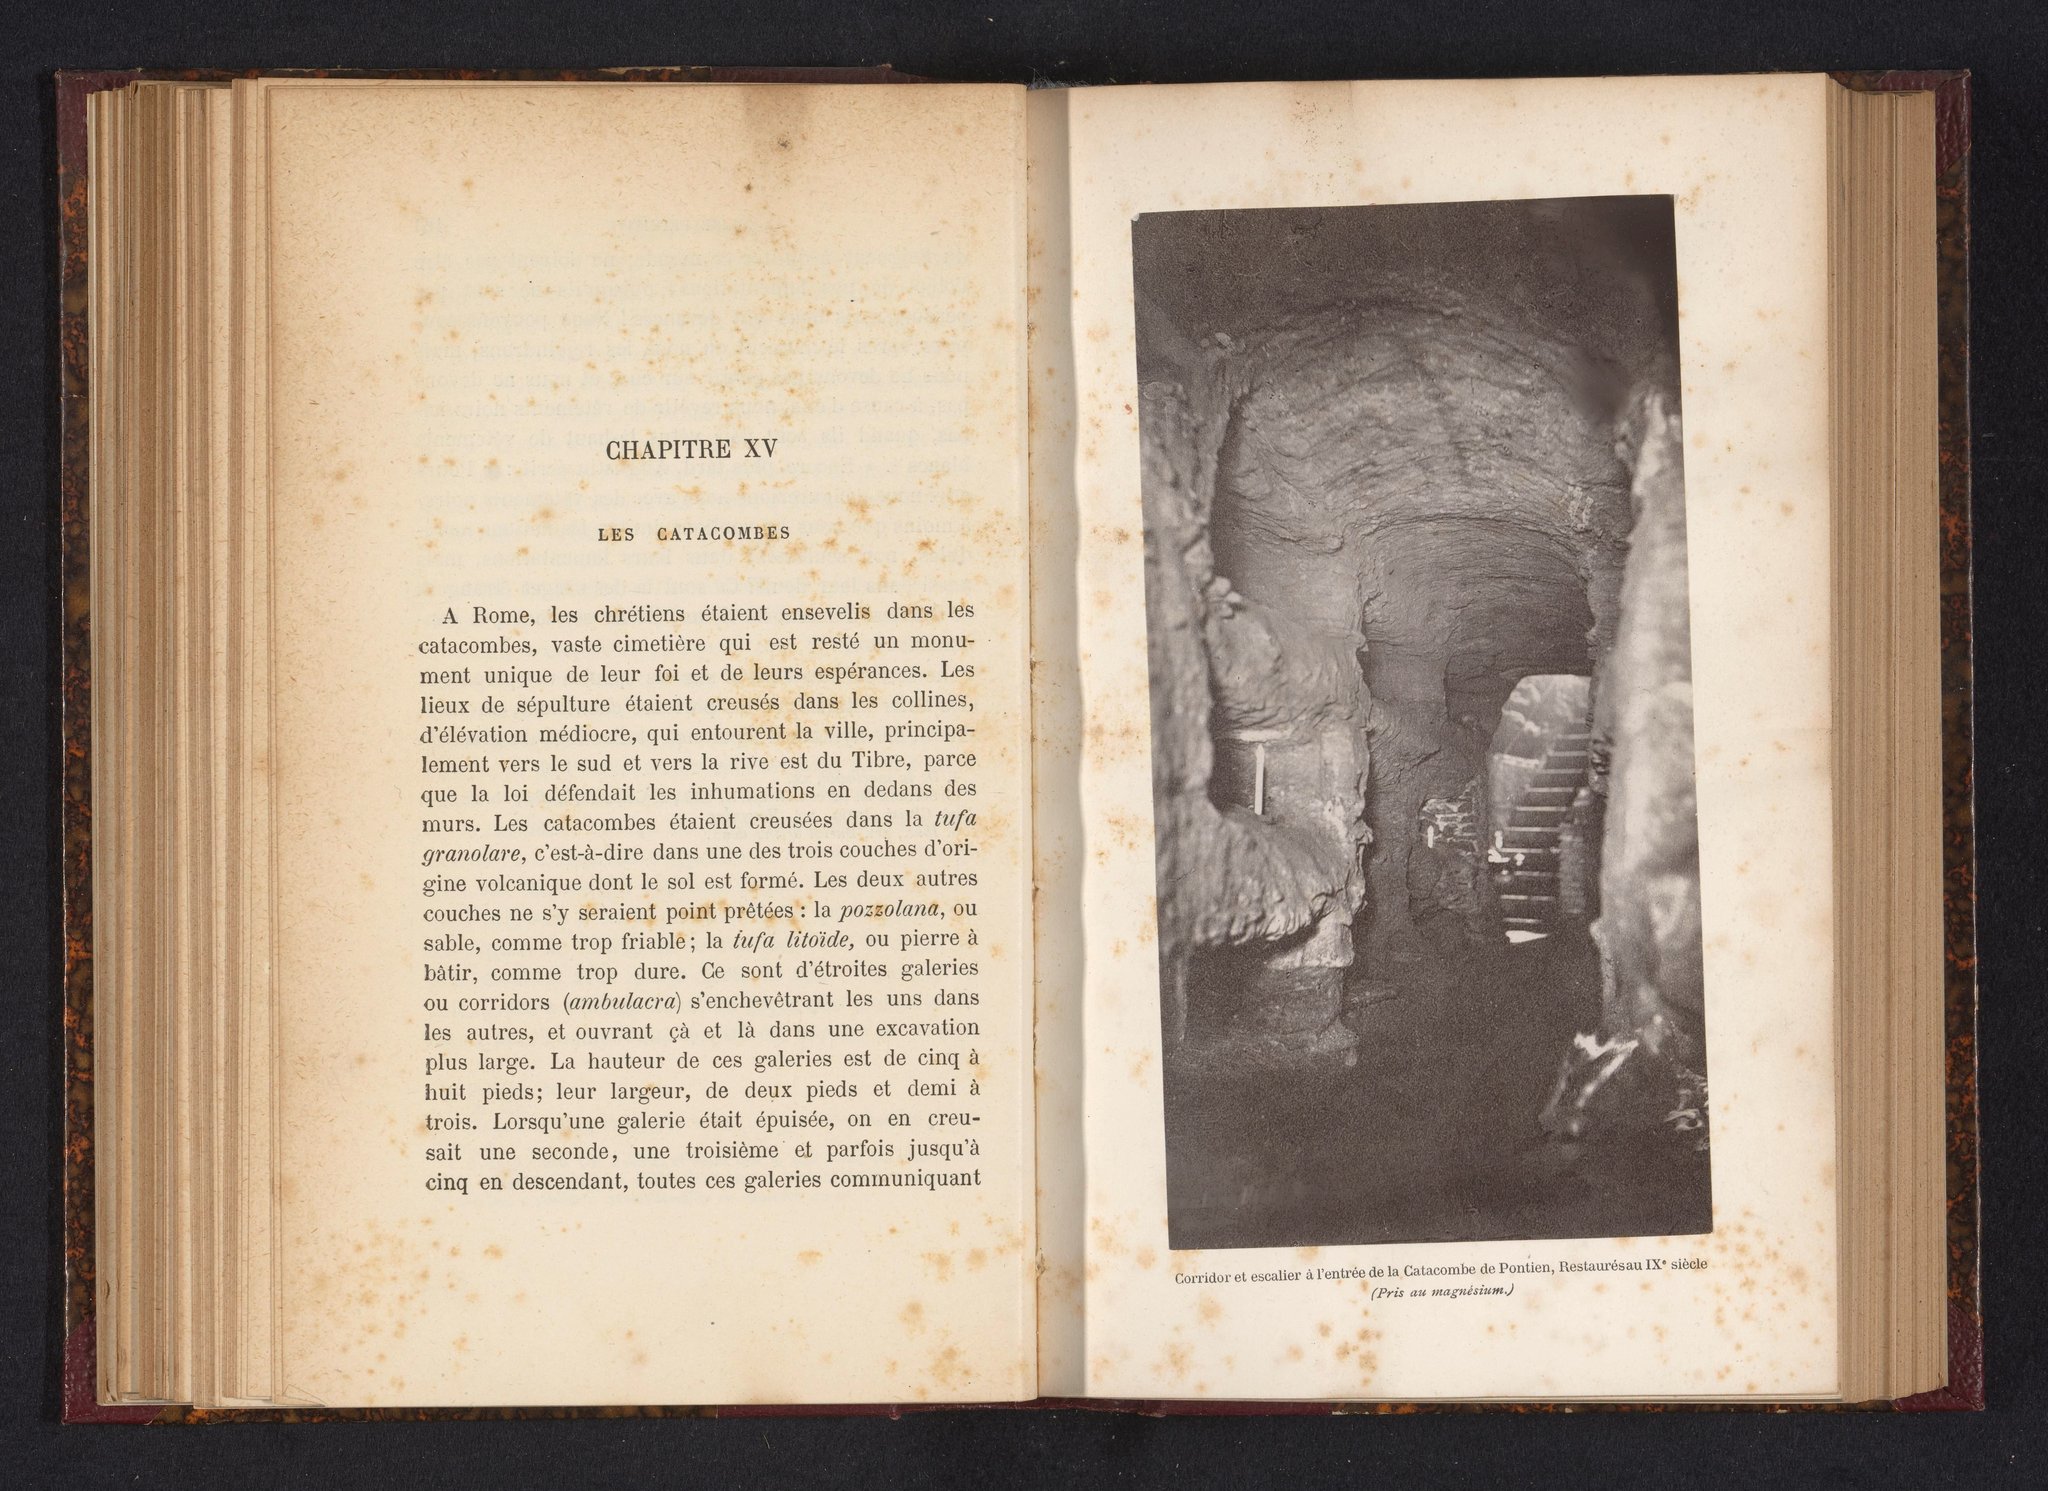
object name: page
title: Interieur van de Catacomben van Sint-Calixtus te Rome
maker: Anonymous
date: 1876-1886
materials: paper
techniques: woodburytype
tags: catacombs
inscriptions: inscription: ‘Corridor et escalier (...) Restaurésau IXe siècle’